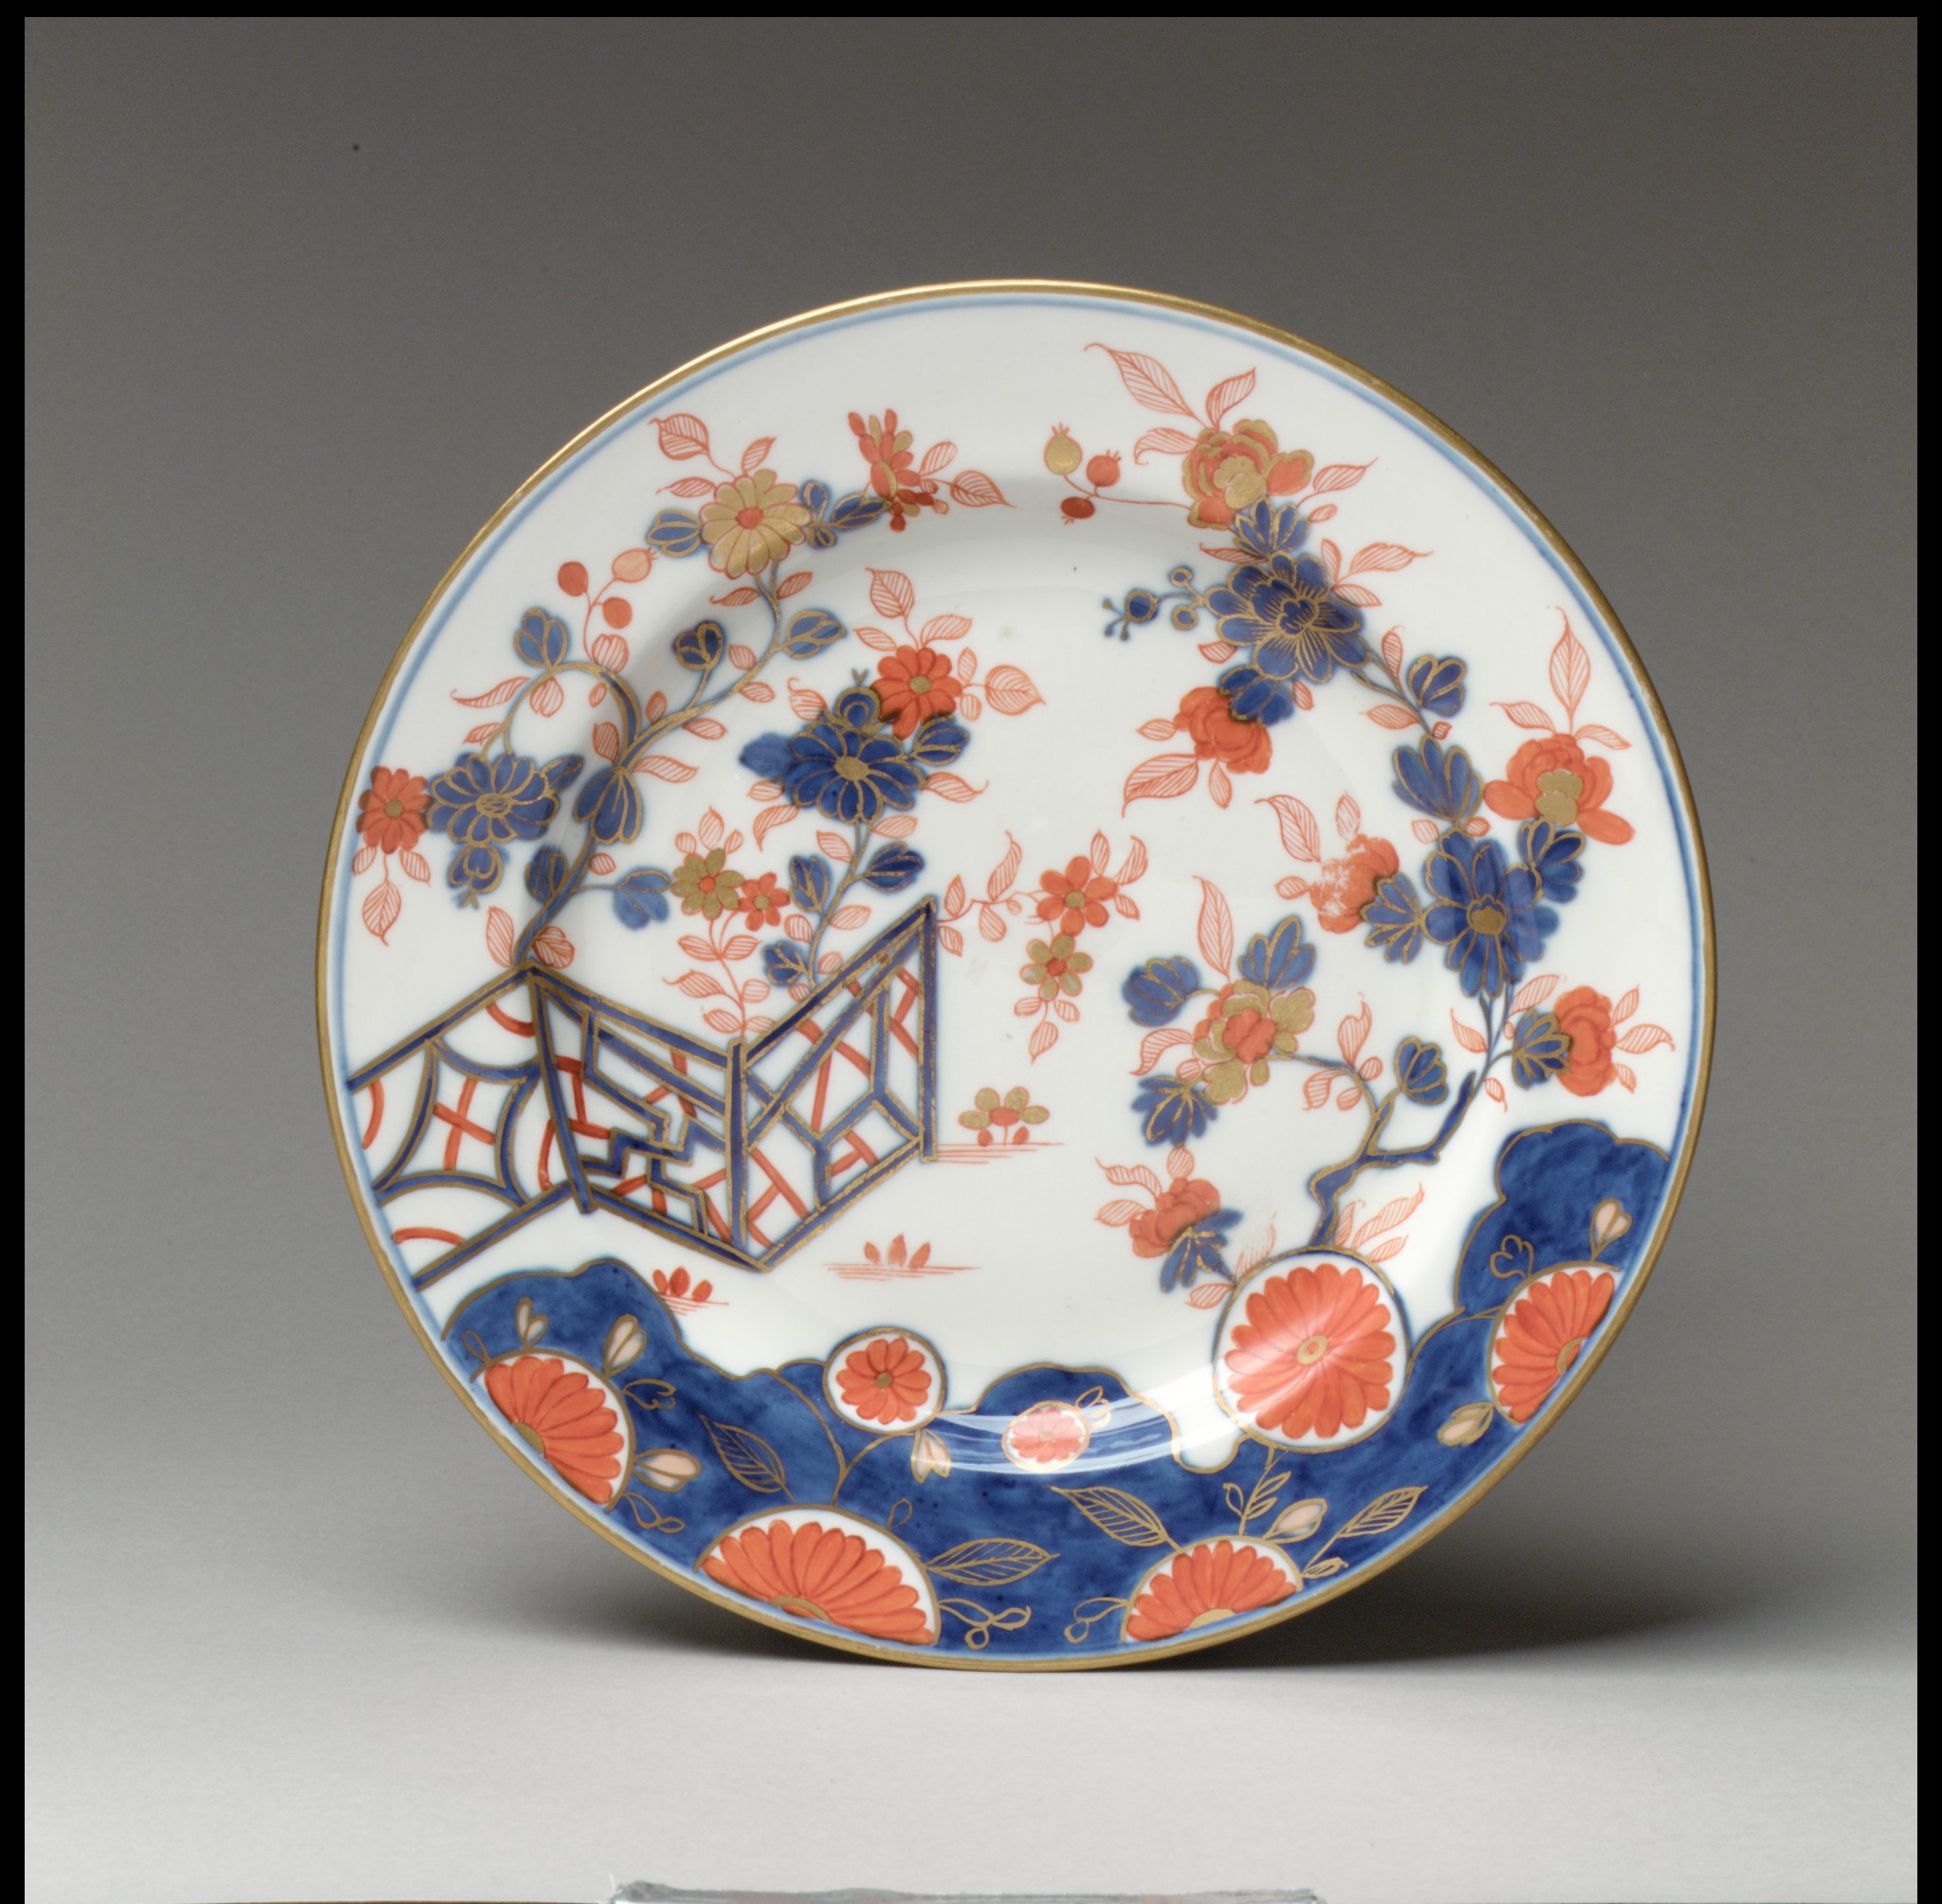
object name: plate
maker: imperial porcelain manufactory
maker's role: manufactory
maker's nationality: austrian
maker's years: 1744-1864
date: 1801-1833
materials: hard paste porcelain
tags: flowers